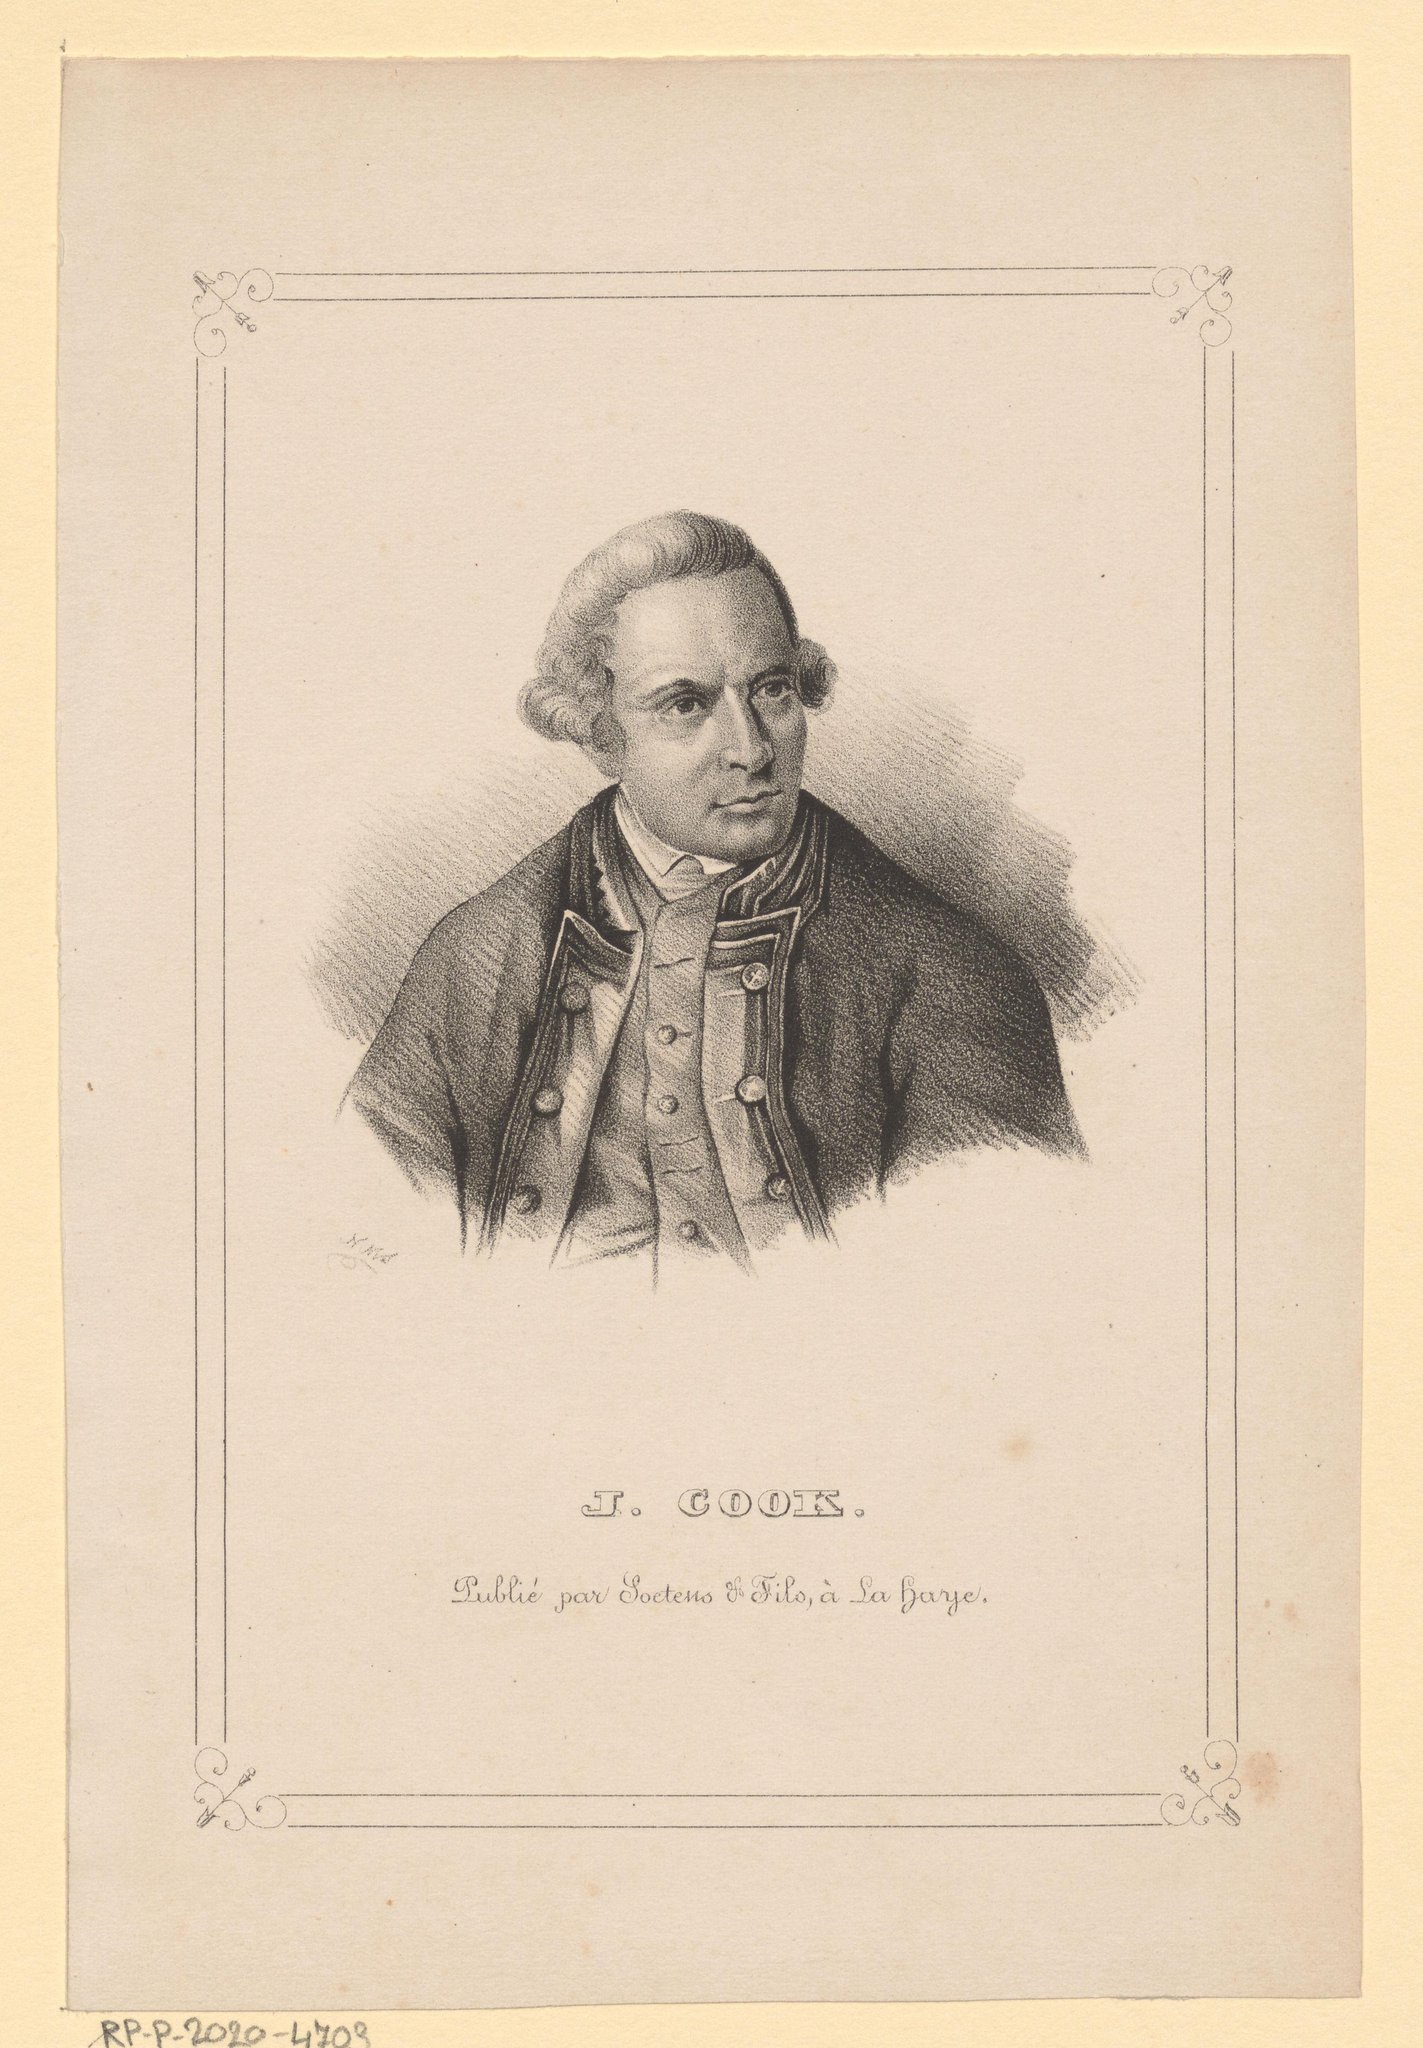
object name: print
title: Portret van James Cook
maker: nicolaas martinus schild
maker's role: draughtsman, print maker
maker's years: 1822-1840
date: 1837-1840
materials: paper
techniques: lithograph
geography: the hague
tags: james cook, historical persons